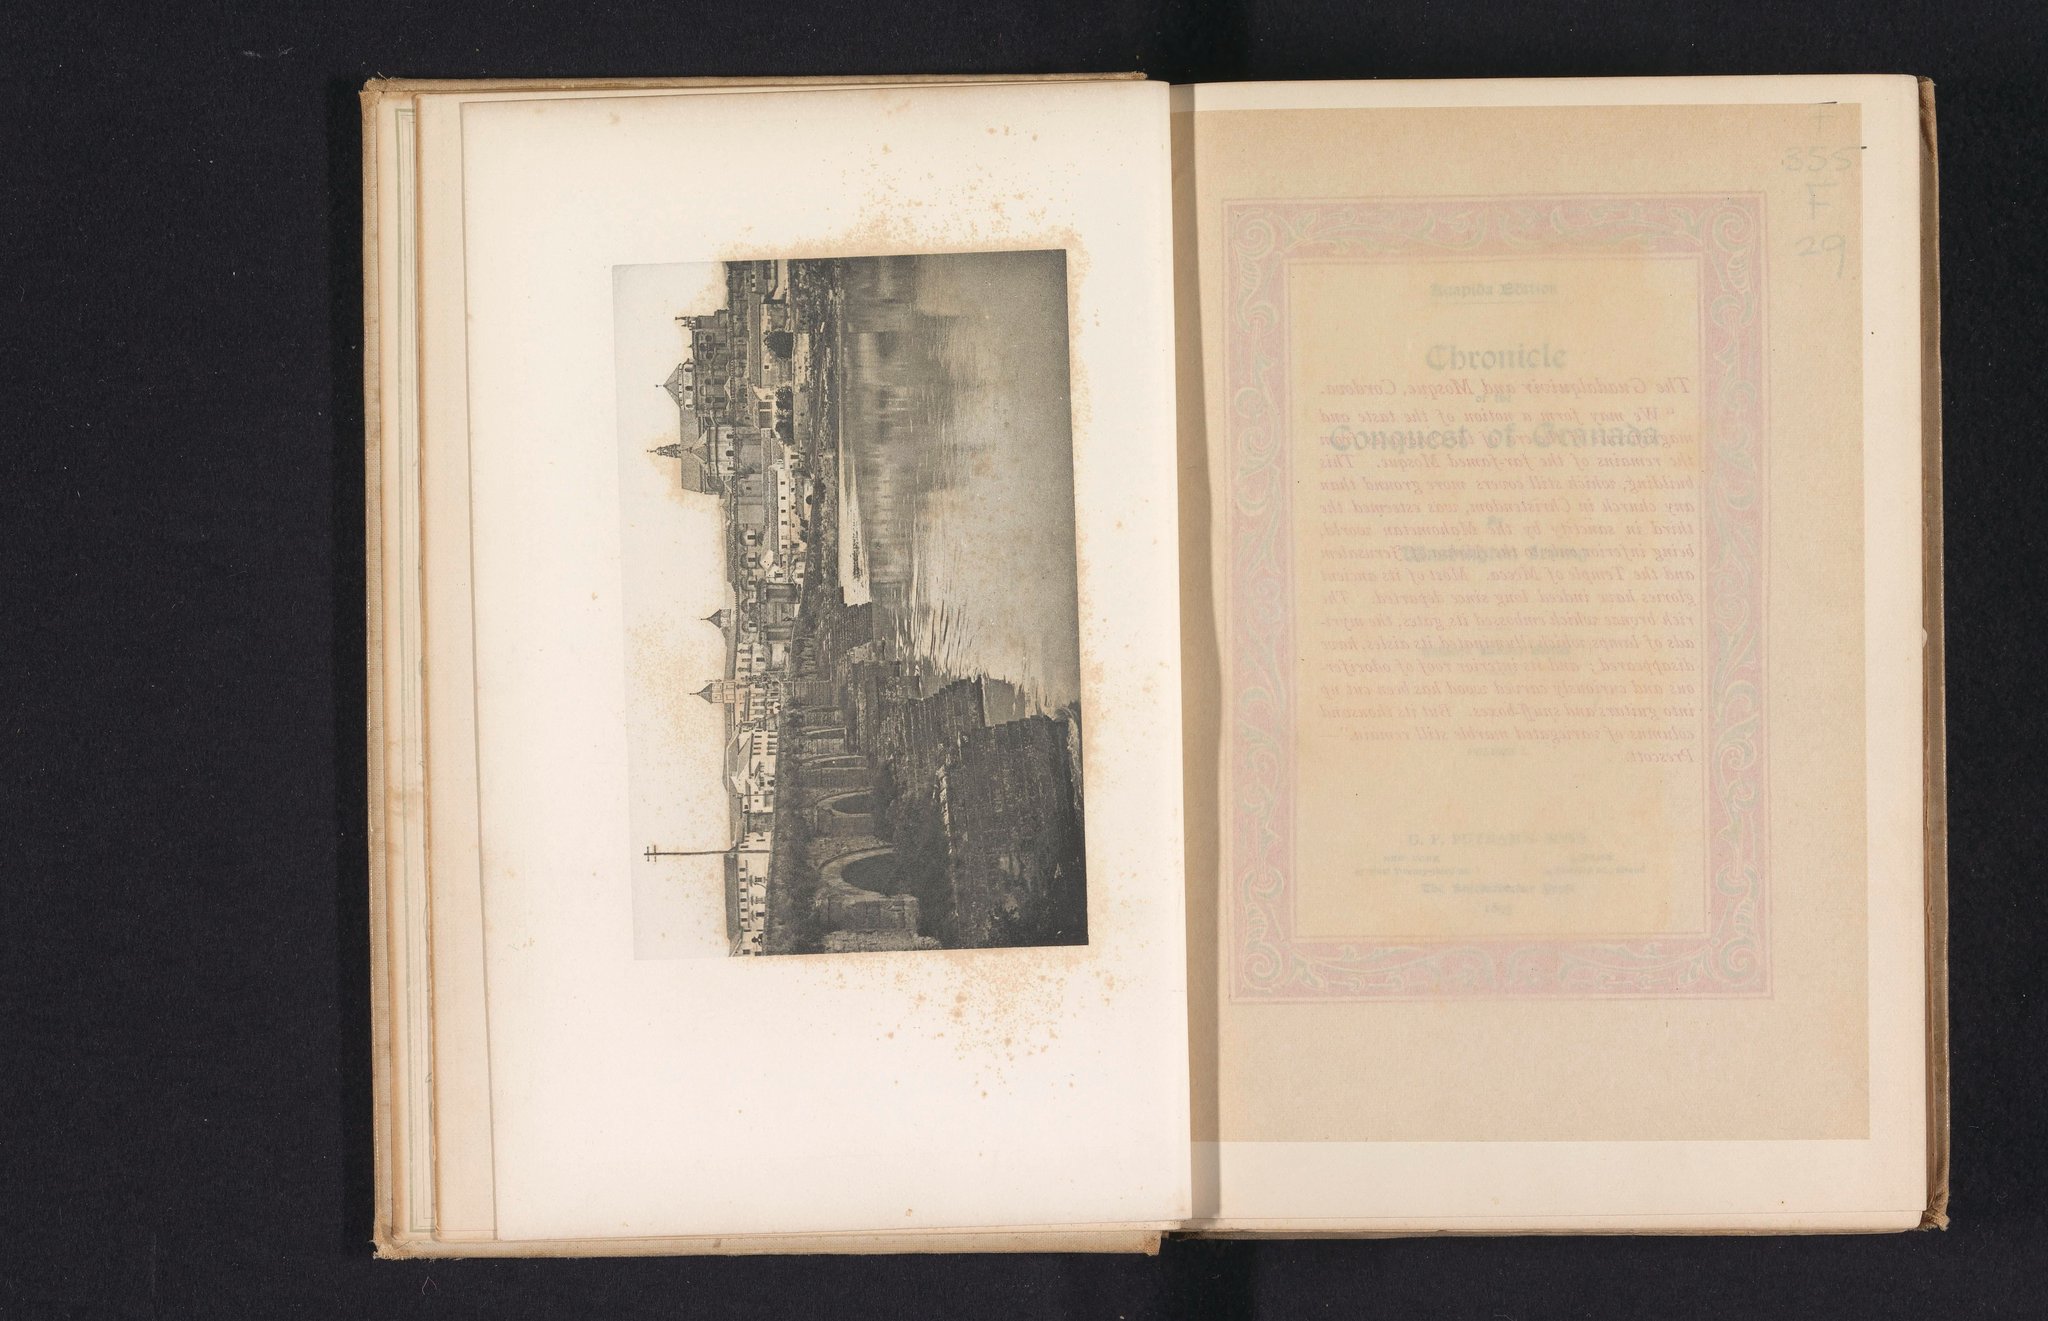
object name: photomechanical print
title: Gezicht op de Guadalquivir en de Mezquita in Córdoba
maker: Anonymous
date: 1883-1893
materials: paper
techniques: photoaquatint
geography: córdoba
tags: temple, shrine ~ islam, mohammedanism, bridge in city across river, canal, etc.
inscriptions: inscription: ‘“ We may form a notion of the taste [...] But its thousand columns of variegated marble still remain.” Prescott.’